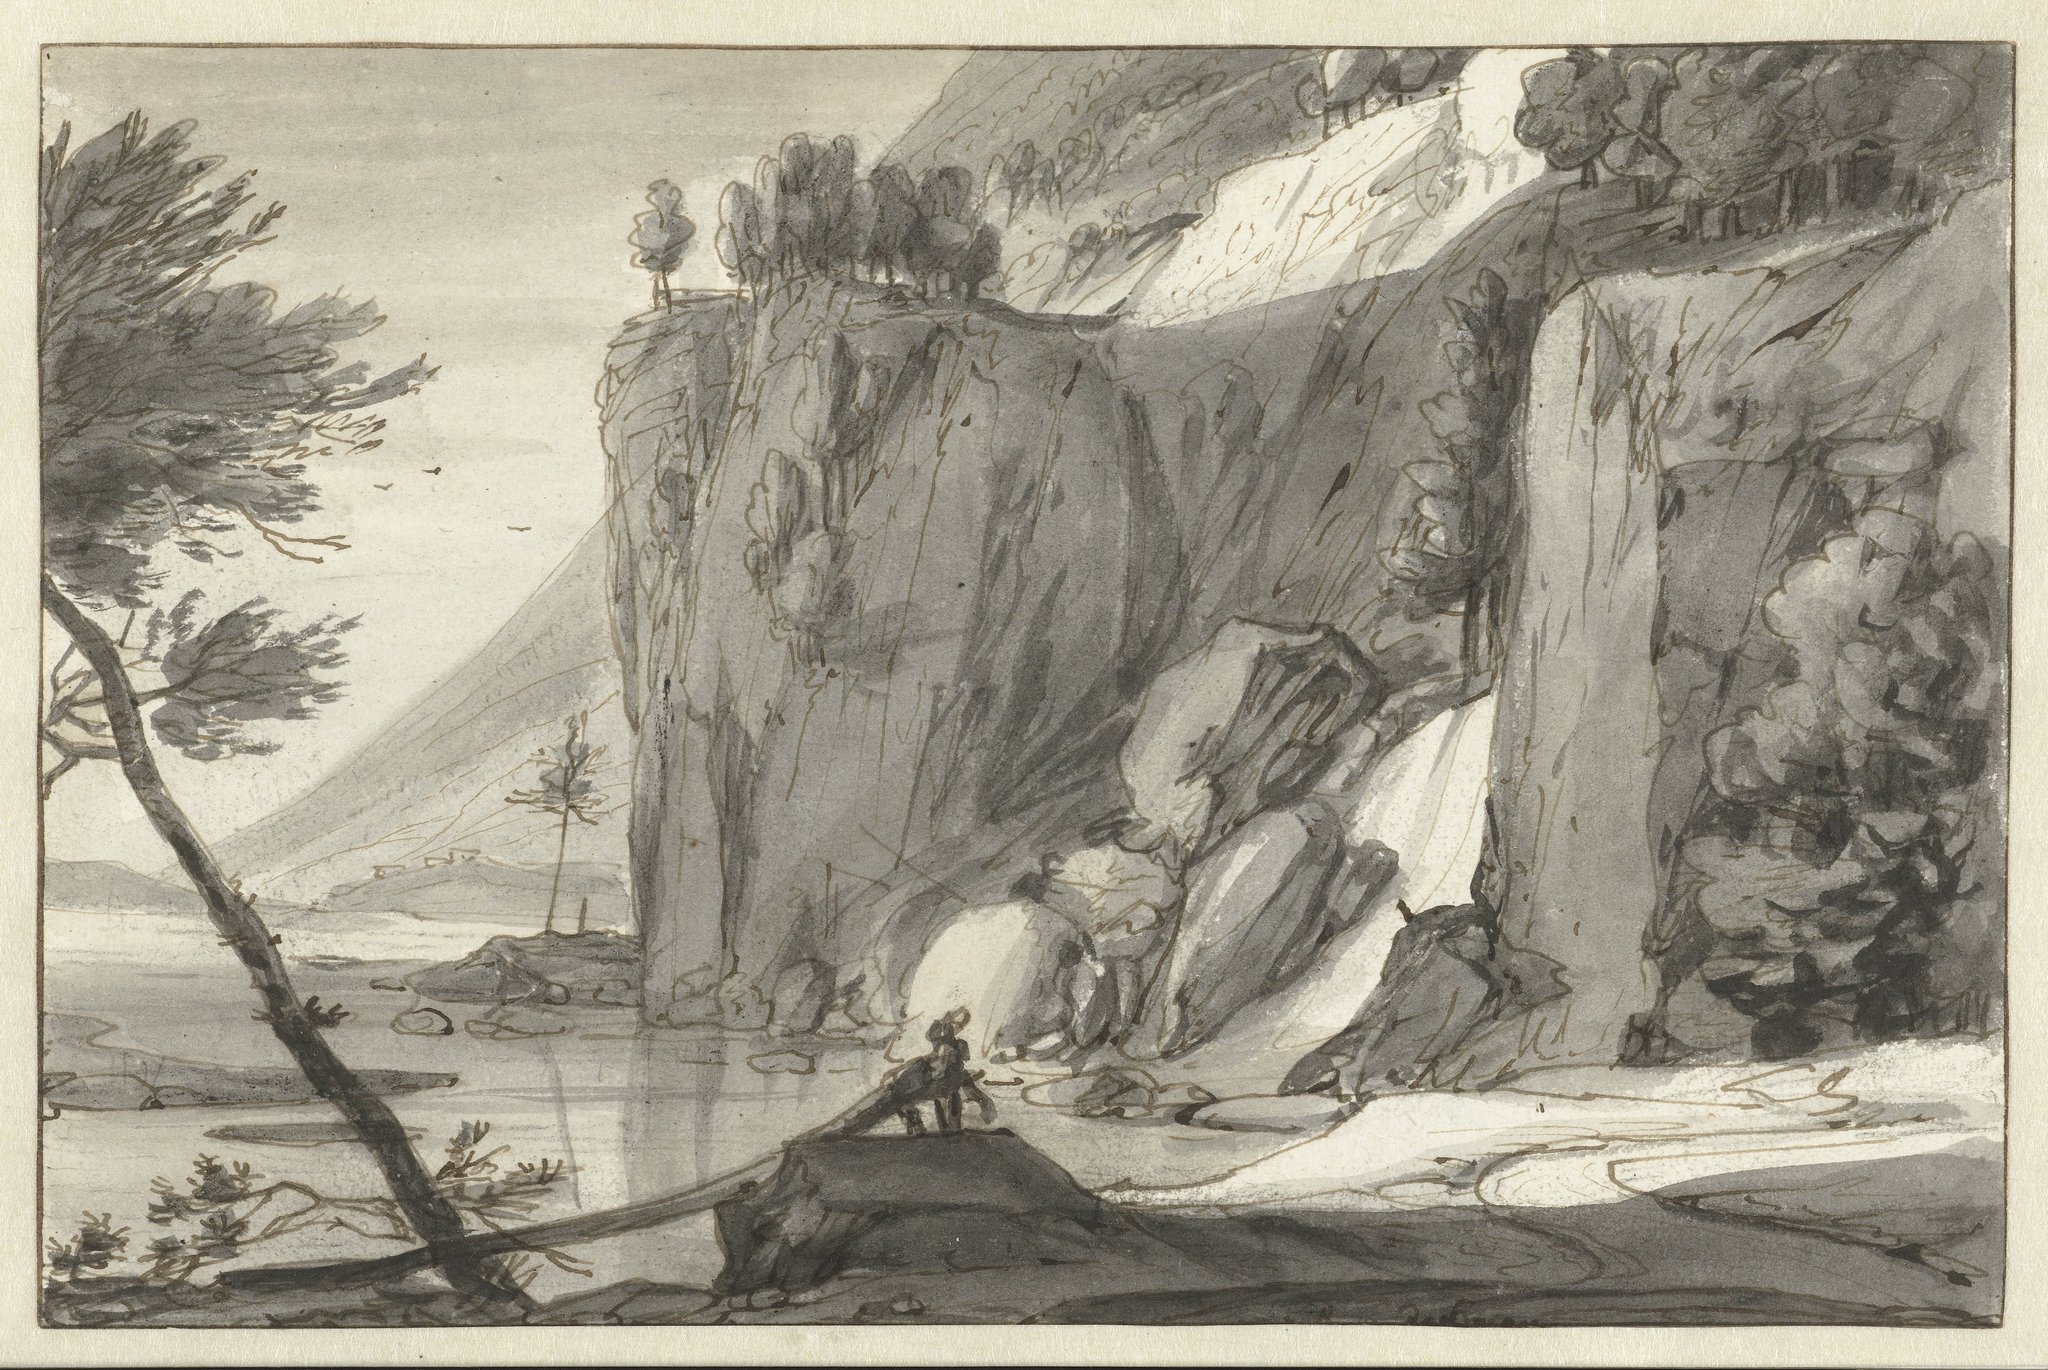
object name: drawing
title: Mountainous Coastal Landscape with Steep Cliffs on the Right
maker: roelant roghman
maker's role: draughtsman, painter, print maker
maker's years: 1627-1692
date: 1660-1670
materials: chalk, ink, paper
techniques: brush, pen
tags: landscapes with waters, waterscapes, seascapes (in the temperate zone), mountains